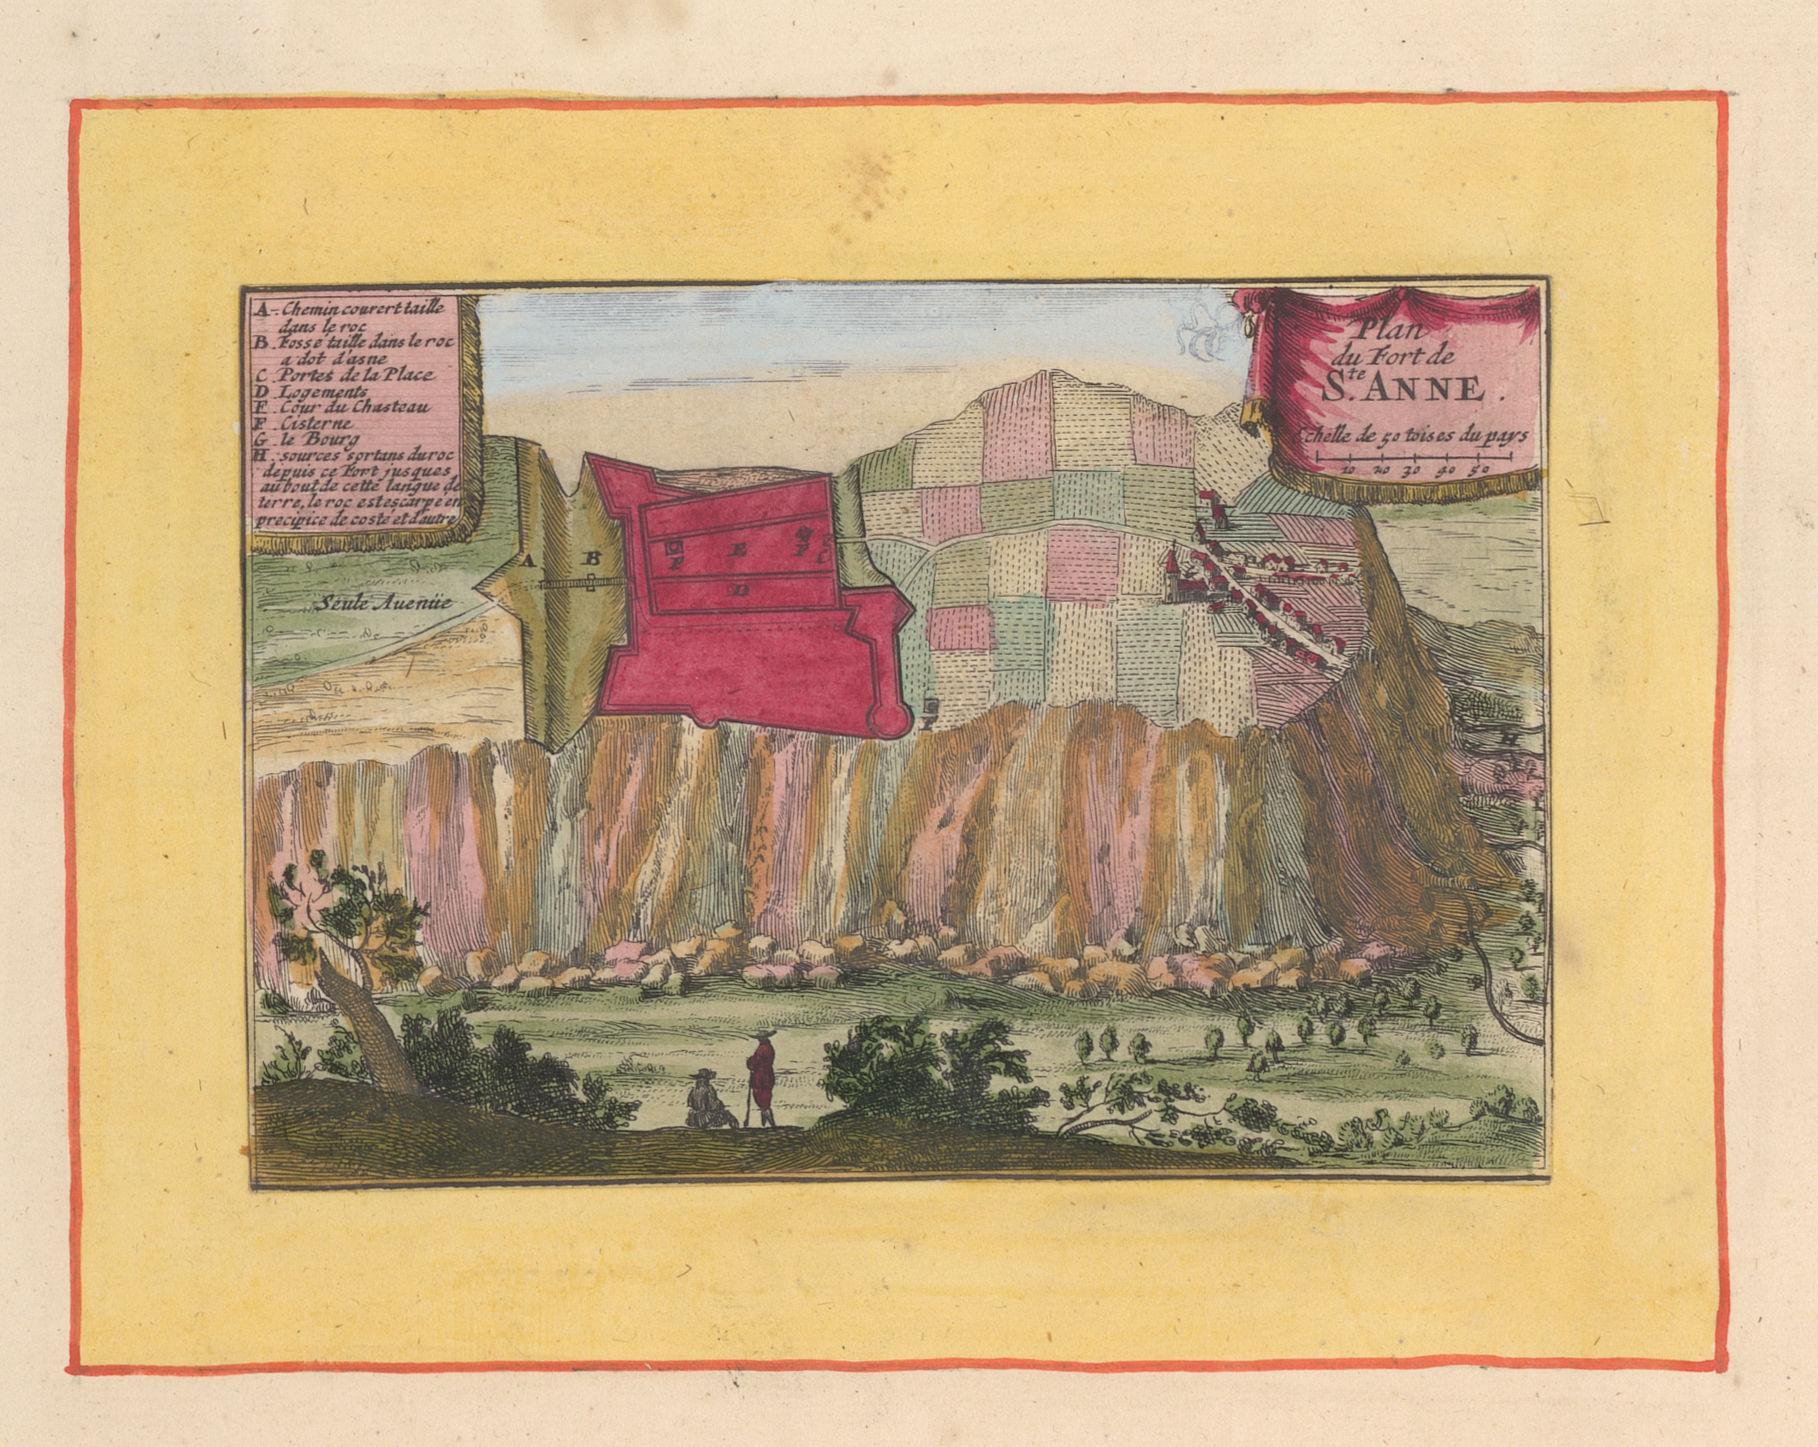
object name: area plan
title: Plattegrond van het kasteel van Sainte-Anne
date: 1600-1699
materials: paper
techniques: engraving, etching, hand coloring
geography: the hague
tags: castle, landscape with tower or castle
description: Deze prent maakt deel uit van een album.